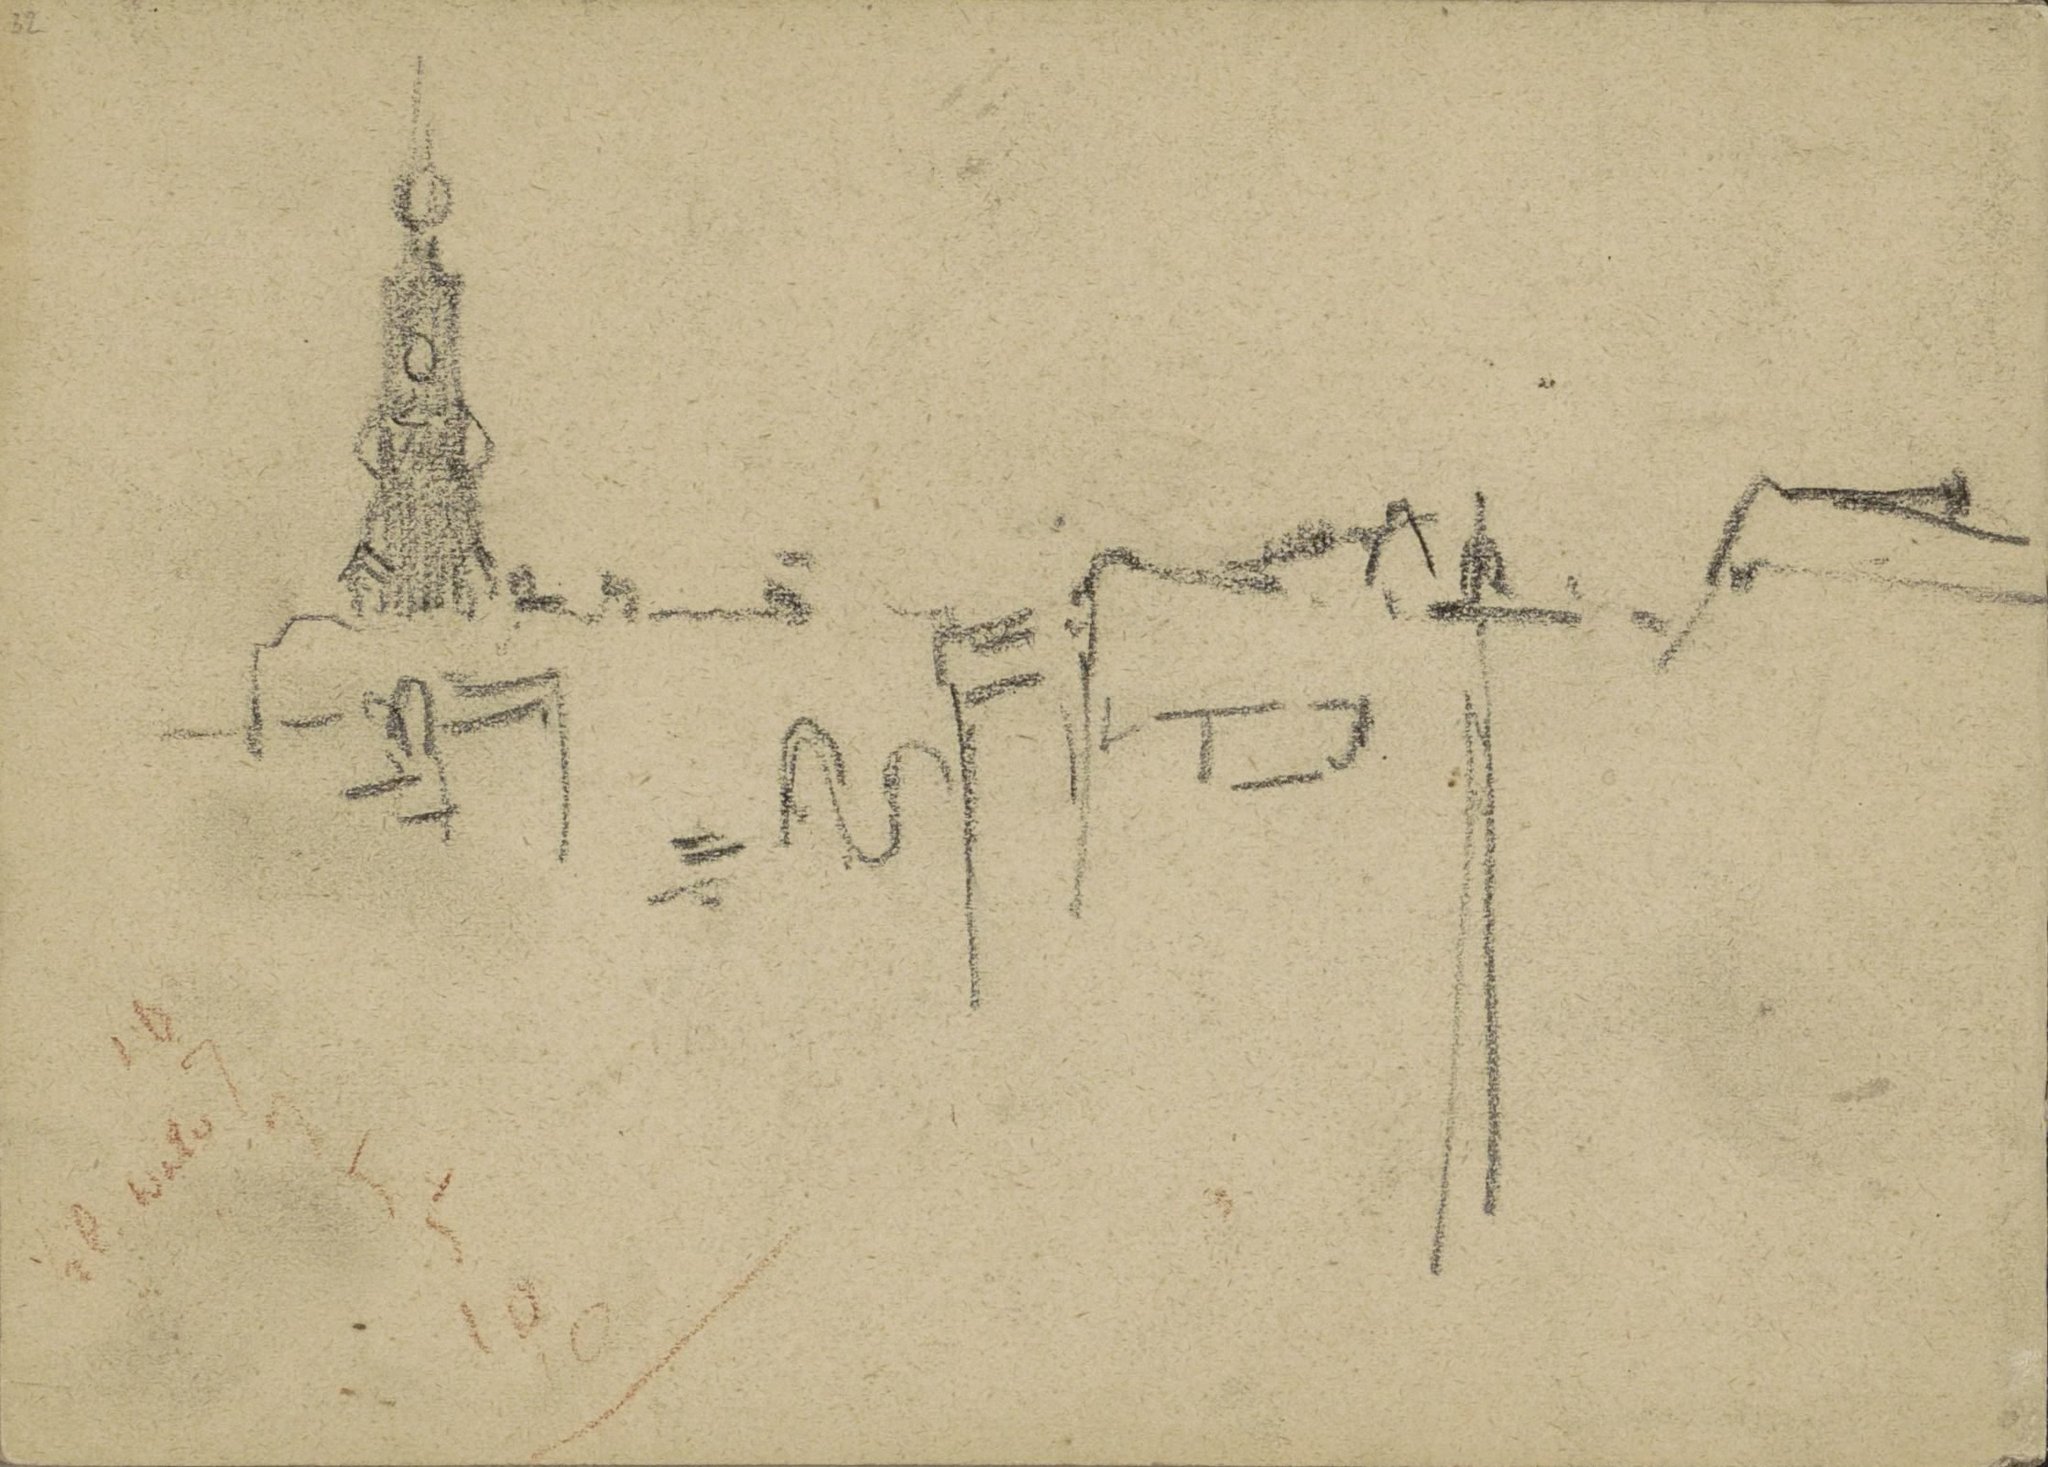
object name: sketchbook leaf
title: Gezicht op Amsterdam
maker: willem witsen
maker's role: draughtsman, painter, print maker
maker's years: 1860-1923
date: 1870-1923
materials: chalk, paper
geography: amsterdam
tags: urban housing, city-view, and landscape with man-made constructions, parts of church exterior and annexes: tower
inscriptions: annotation: ‘[...]’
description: Op de achtergrond mogelijk de toren van de Oude Kerk. Pagina 32 uit een schetsboek met 16 bladen.